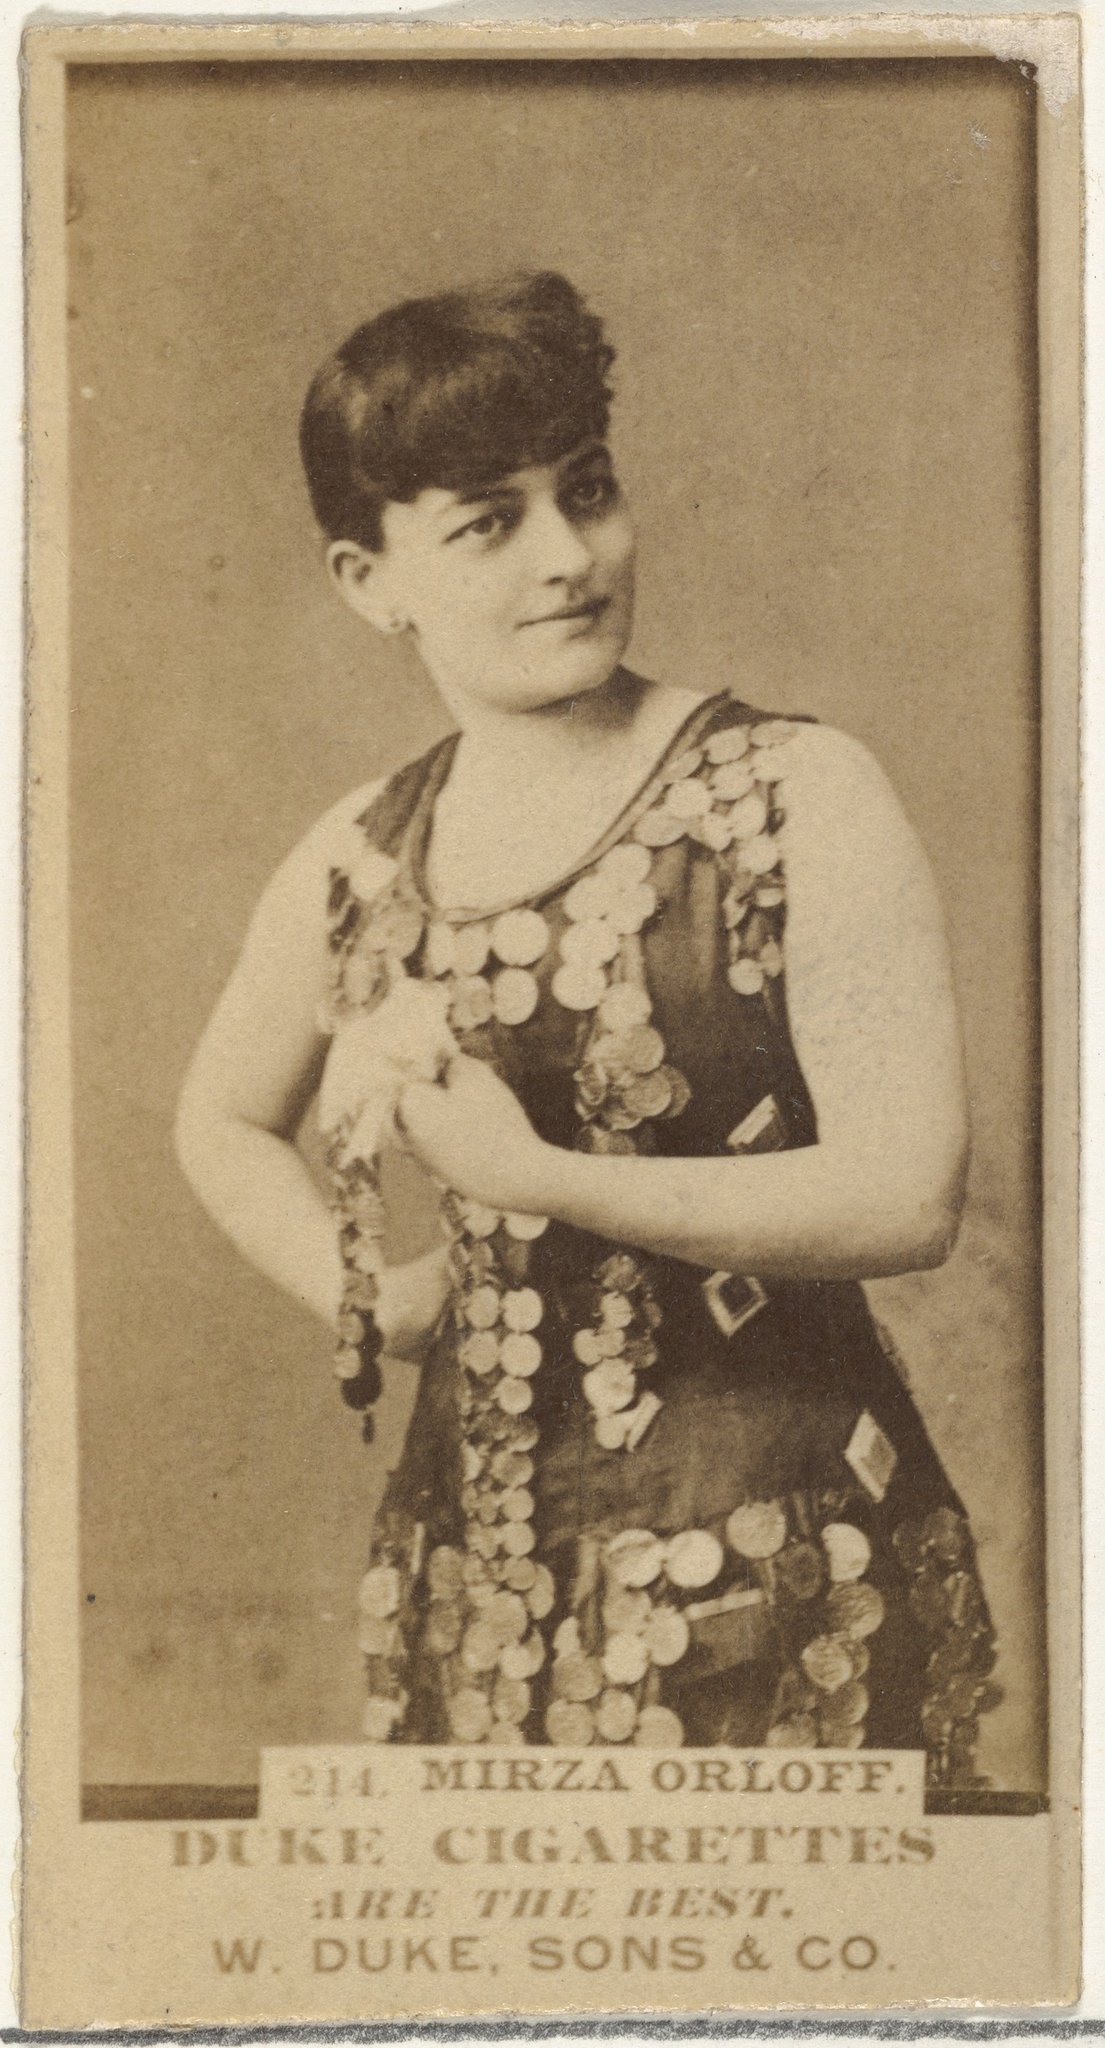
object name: photograph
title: Card Number 214, Mirza Orloff, from the Actors and Actresses series (N145-7) issued by Duke Sons & Co. to promote Duke Cigarettes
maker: w. duke, sons & co.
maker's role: publisher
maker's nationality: american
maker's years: 1870-1920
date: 1880-1889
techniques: albumen silver print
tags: portraits,women,actresses